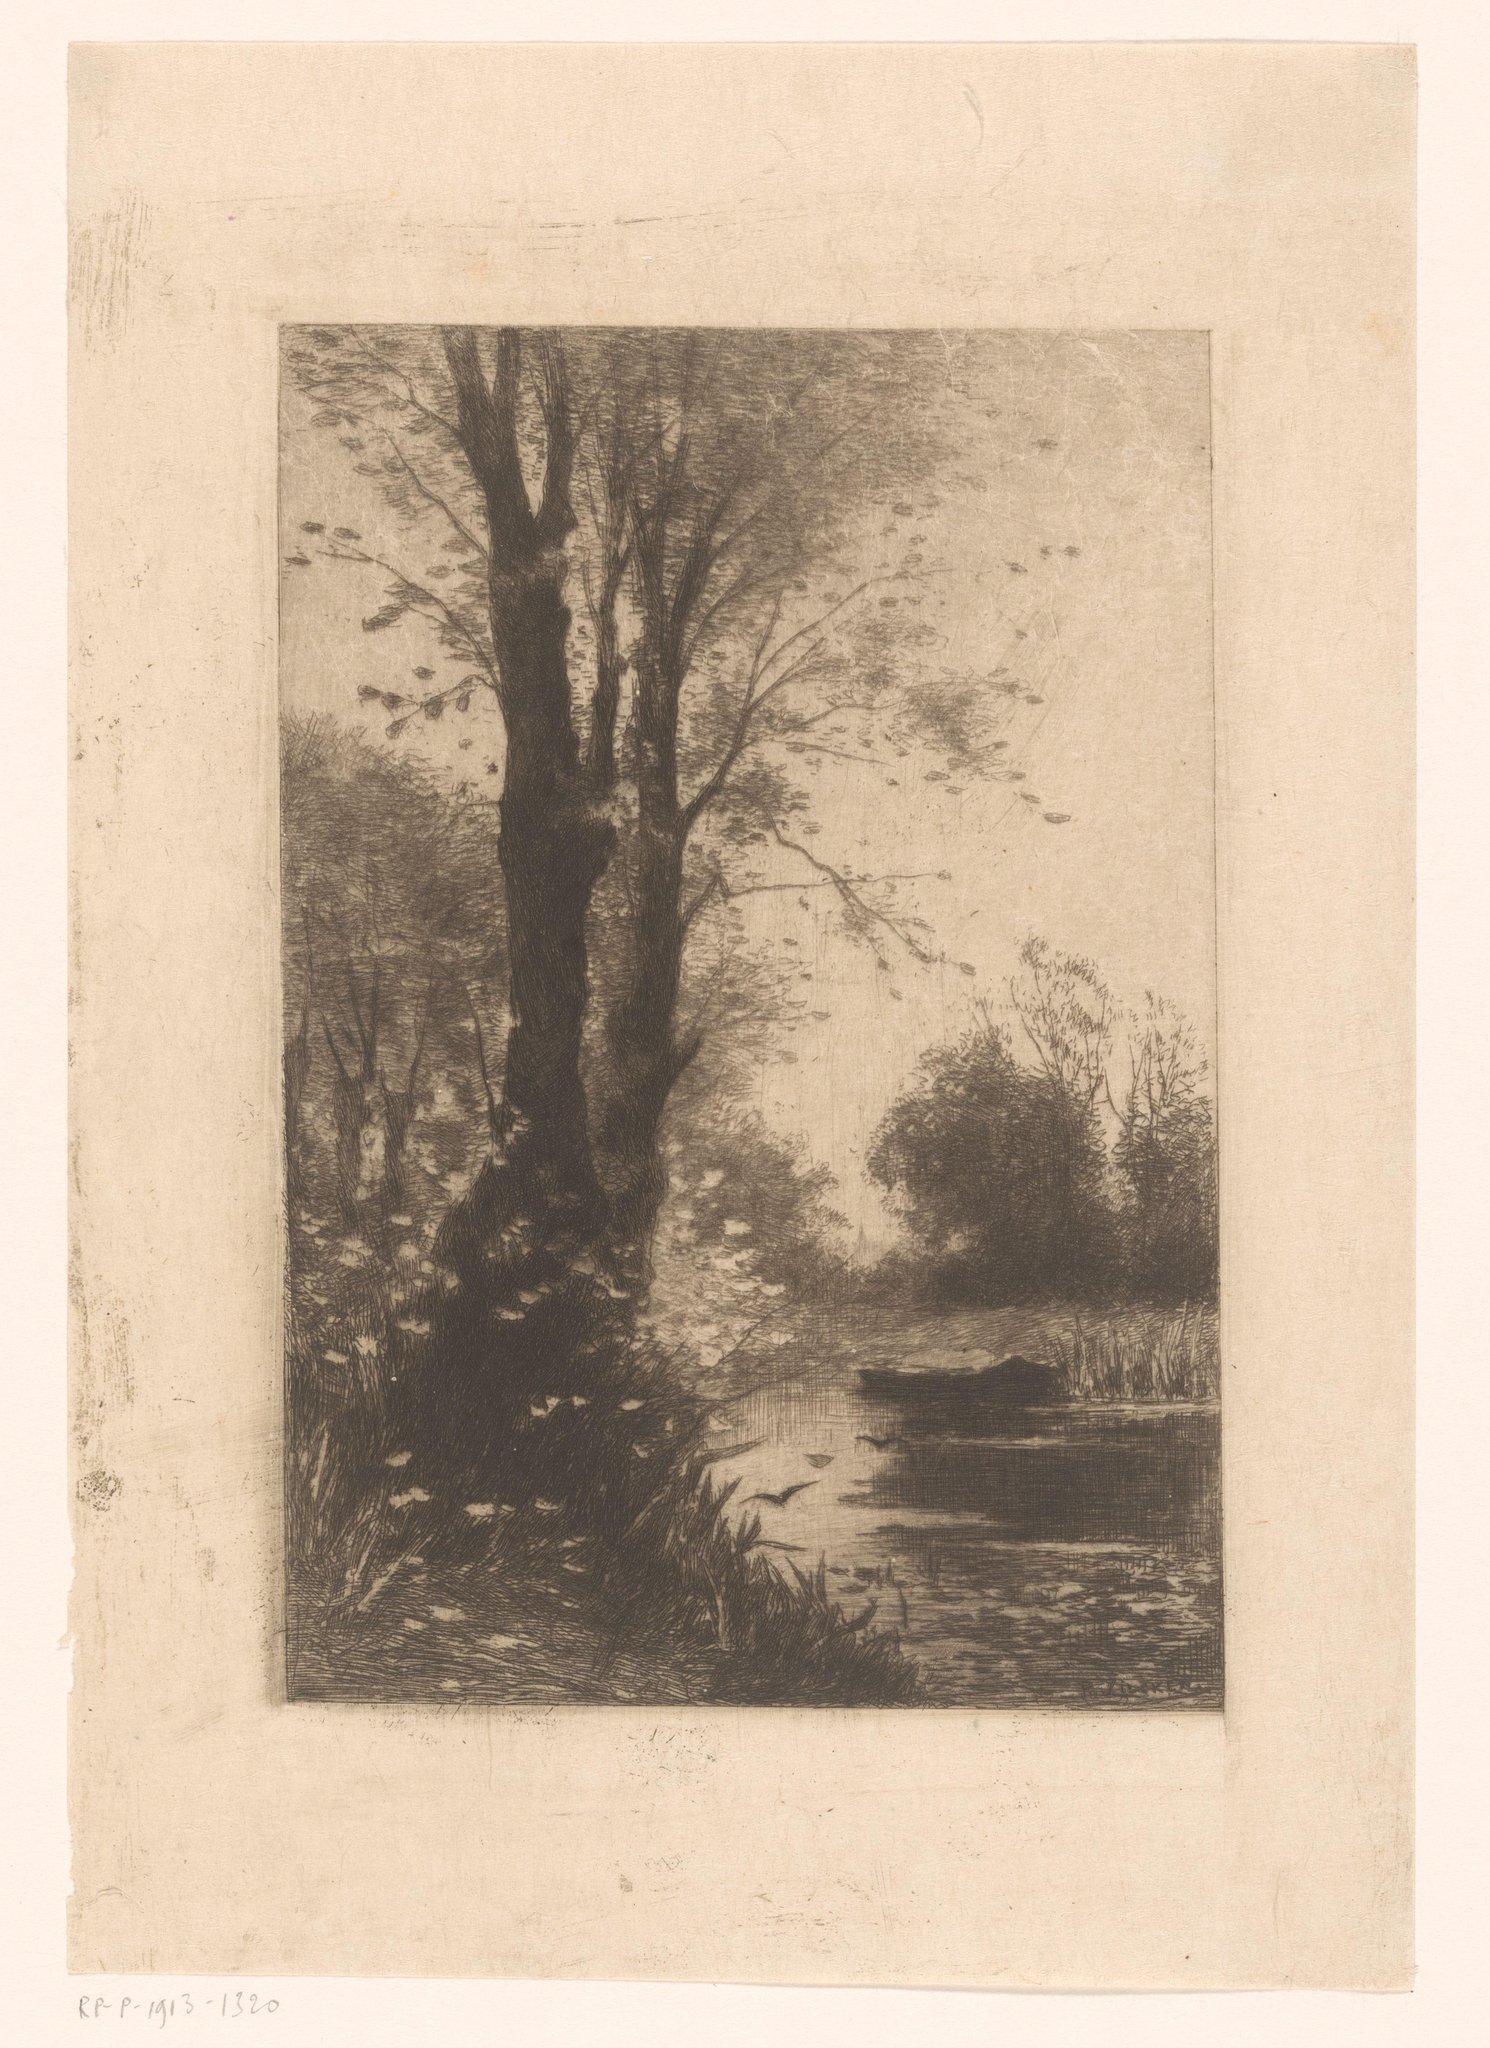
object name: print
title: Herfstochtend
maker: philip zilcken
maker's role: draughtsman, painter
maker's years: 1857-1930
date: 1867-1890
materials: paper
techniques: drypoint, etching, intaglio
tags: trees, pond, pool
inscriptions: collector's mark: Lugt 2233